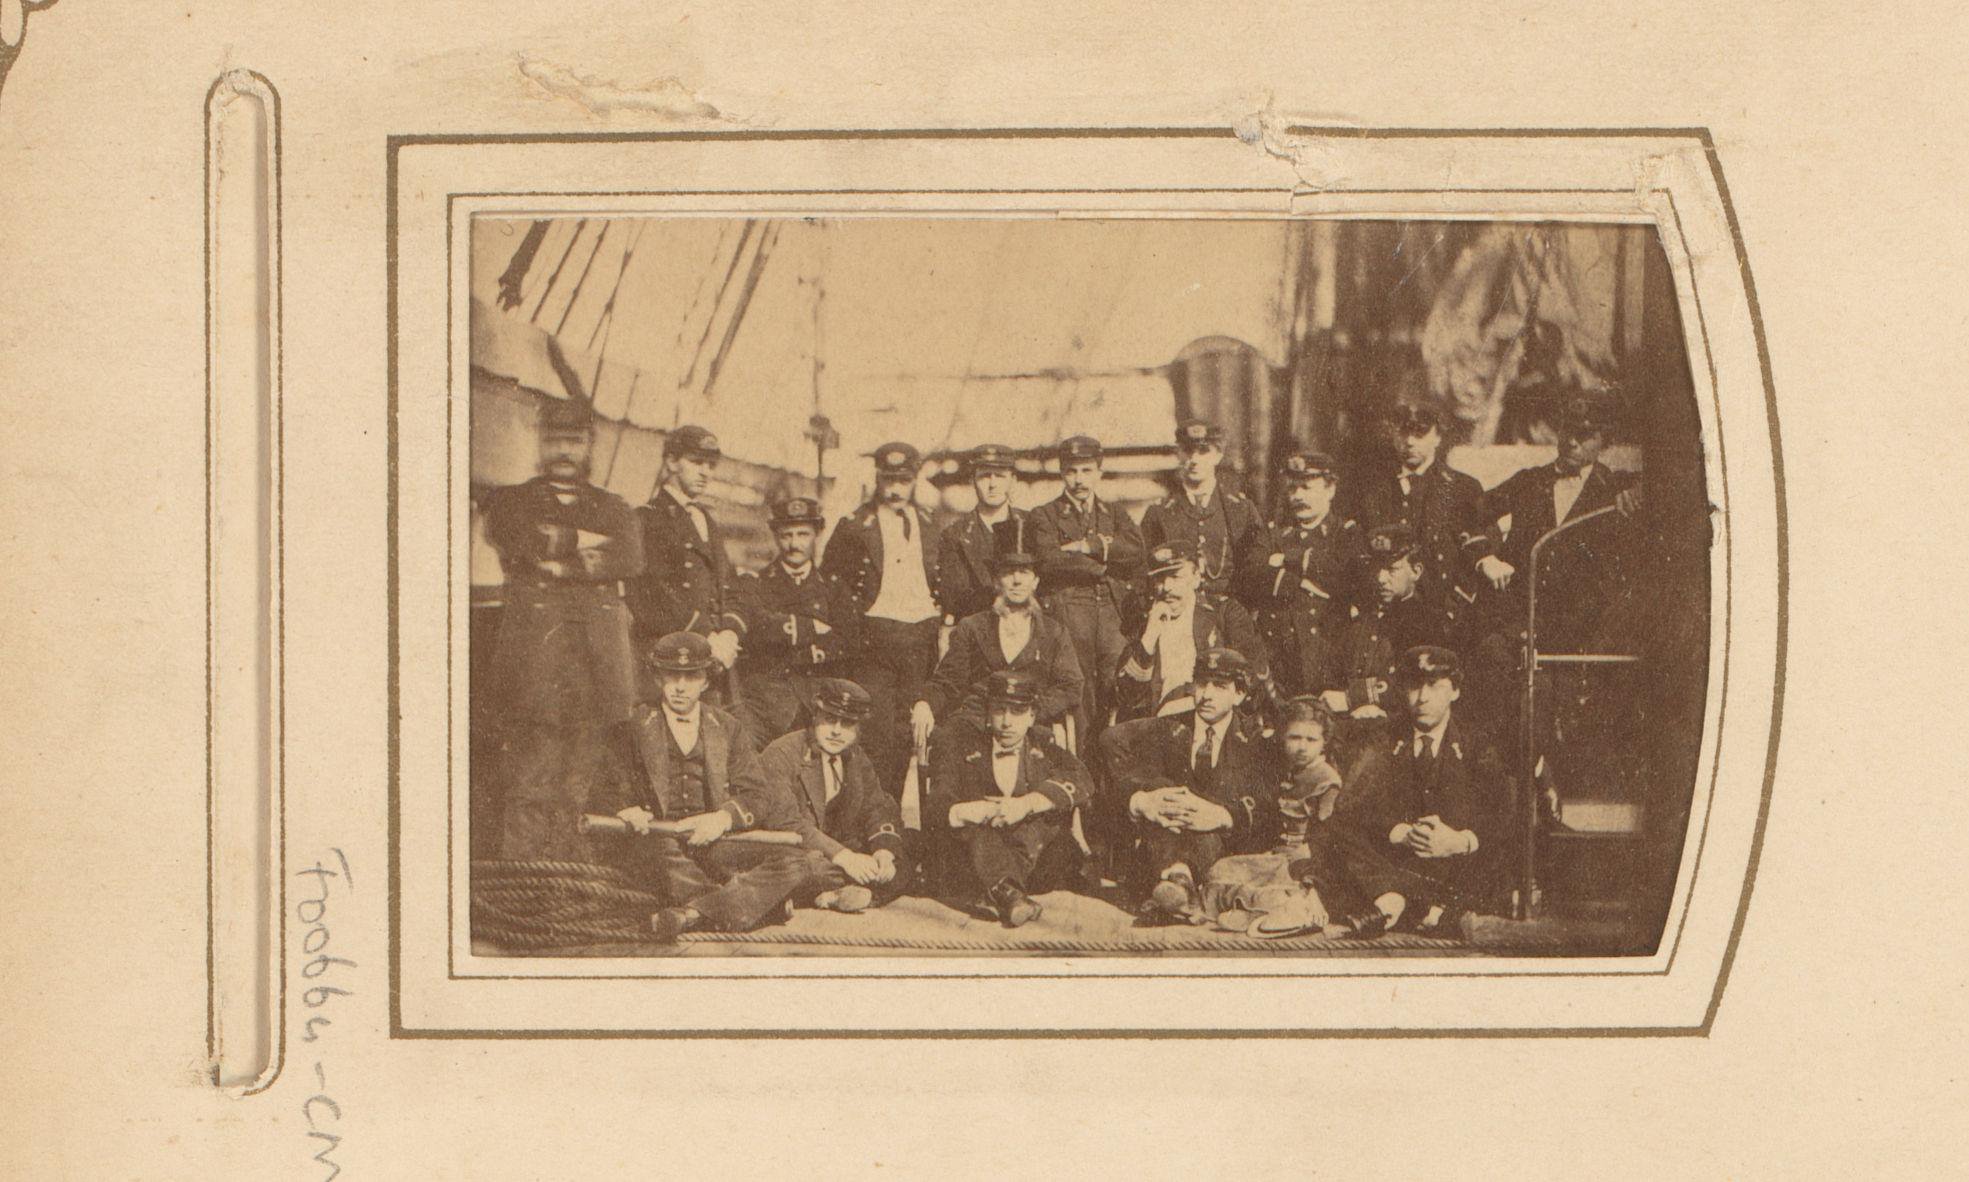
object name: carte de visite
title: Groepsportret van de officieren op Z.M. schroefstoomschip Curaçao, met Willem van Braam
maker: Anonymous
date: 1808-1871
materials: cardboard, photographic support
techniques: albumen print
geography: sydney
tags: willem van braam, steamship, motorship, anonymous historical persons portrayed in a group, in a group-portrait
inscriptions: annotation: ‘État-Major/ Z.M. Schroefstoomschip Curaçao/ in de baai van Sydney/ Aug. 1871/ [...] 23x30x40’